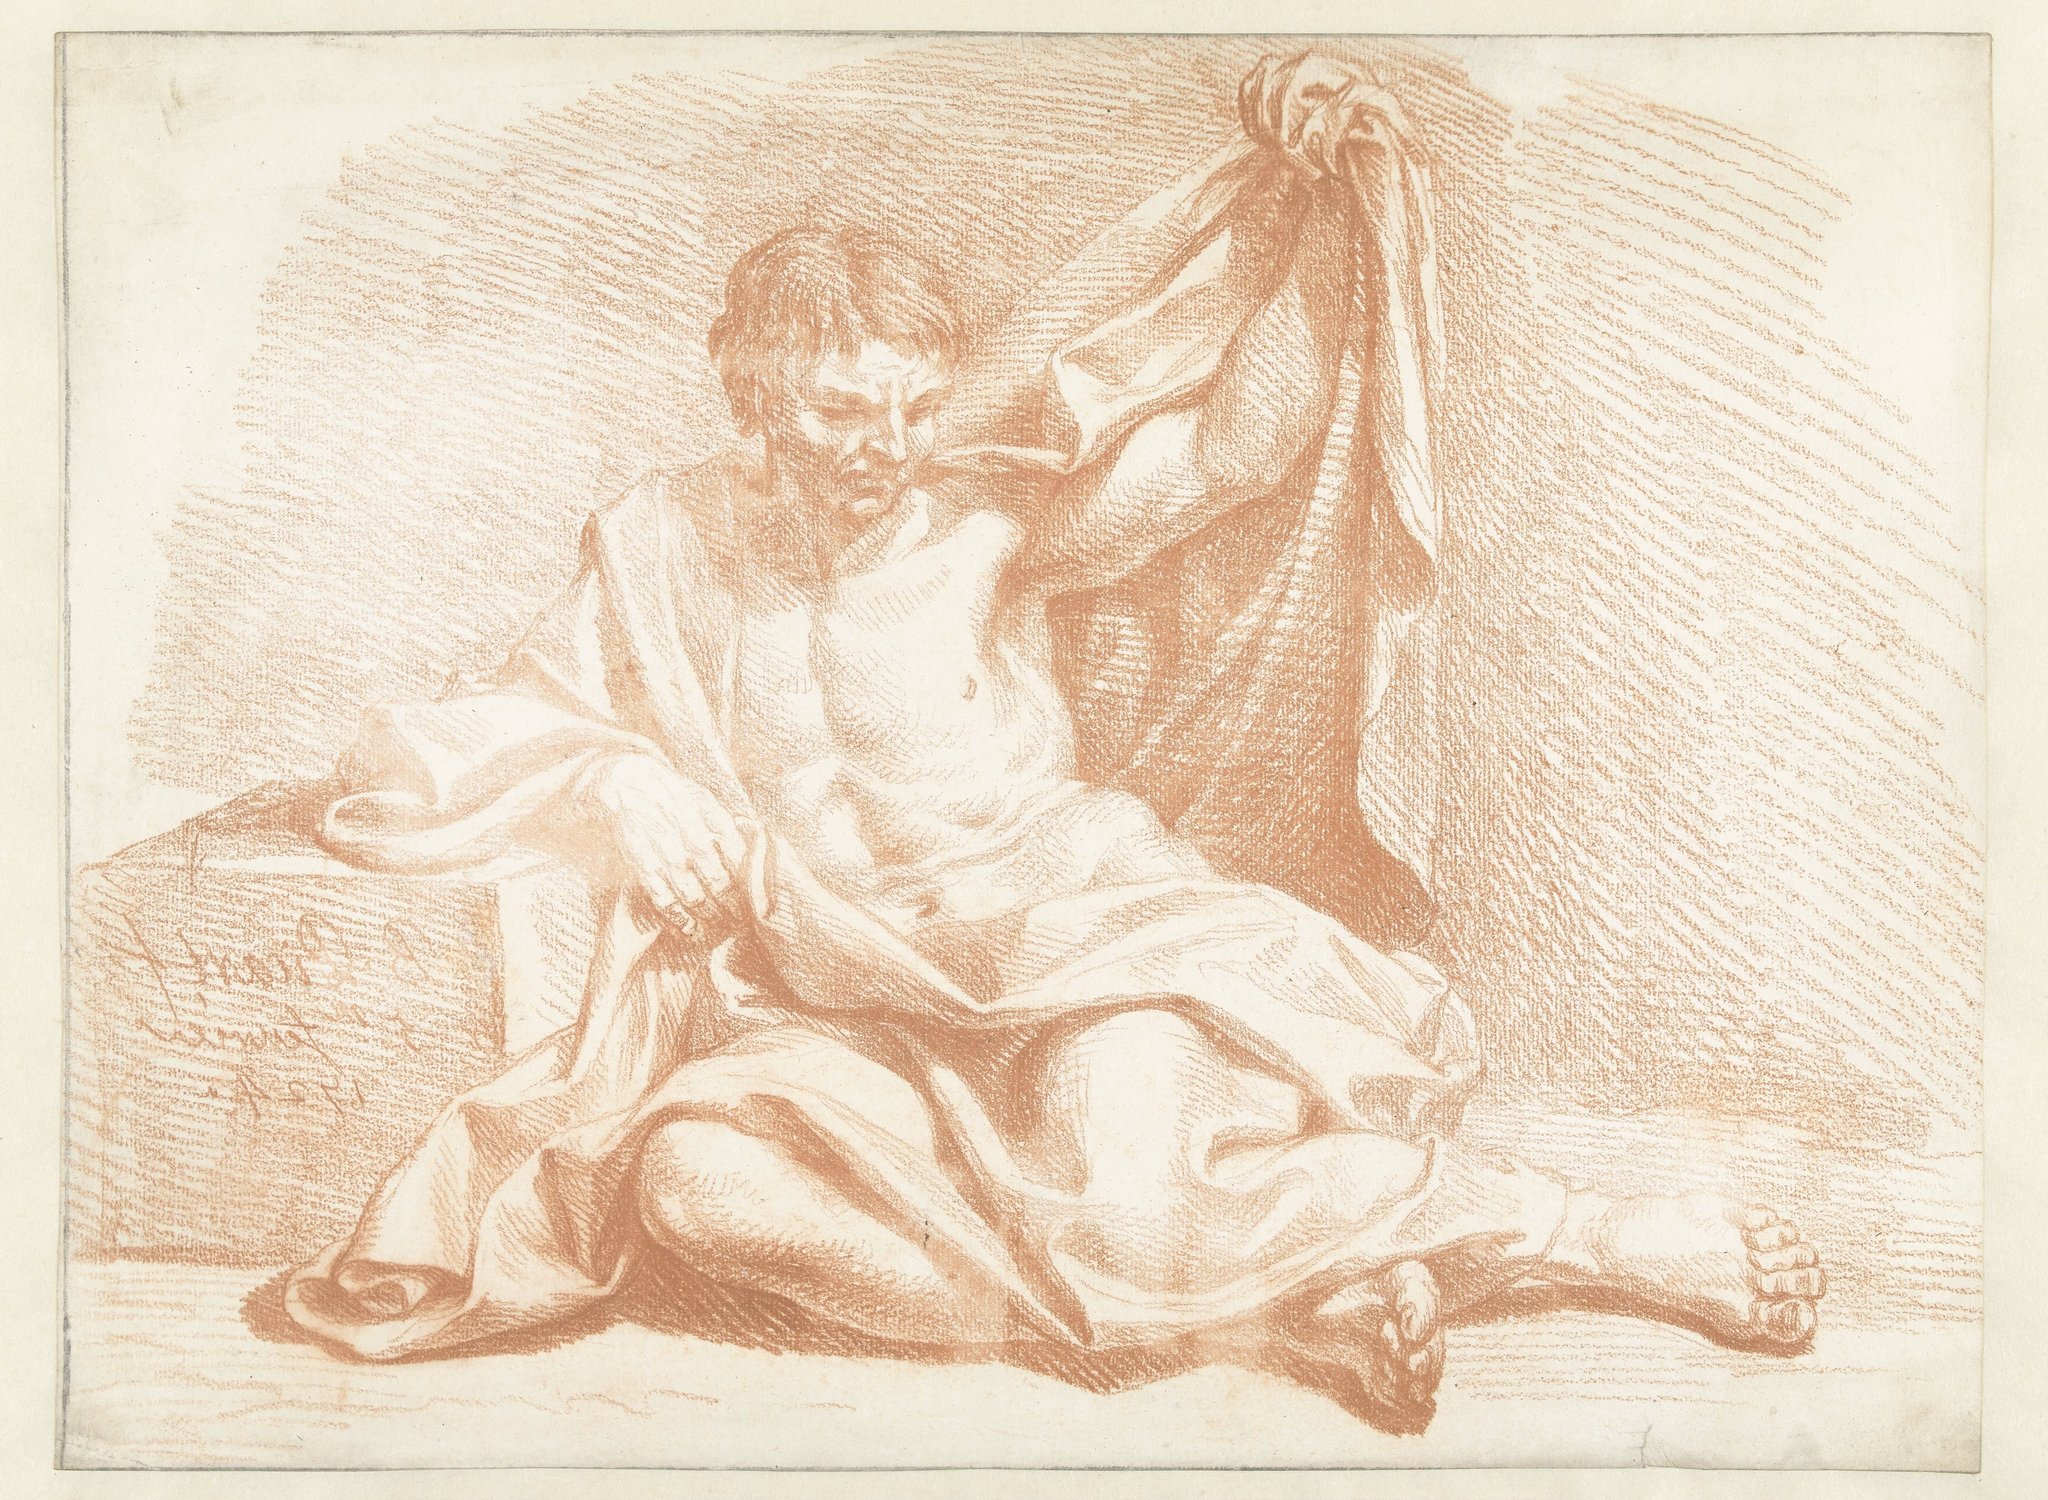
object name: drawing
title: Hoofd van neerziende vrouw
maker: bernard picart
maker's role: draughtsman, print maker, publisher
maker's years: 1673-1733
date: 1683-1733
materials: chalk, paper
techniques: printmaking